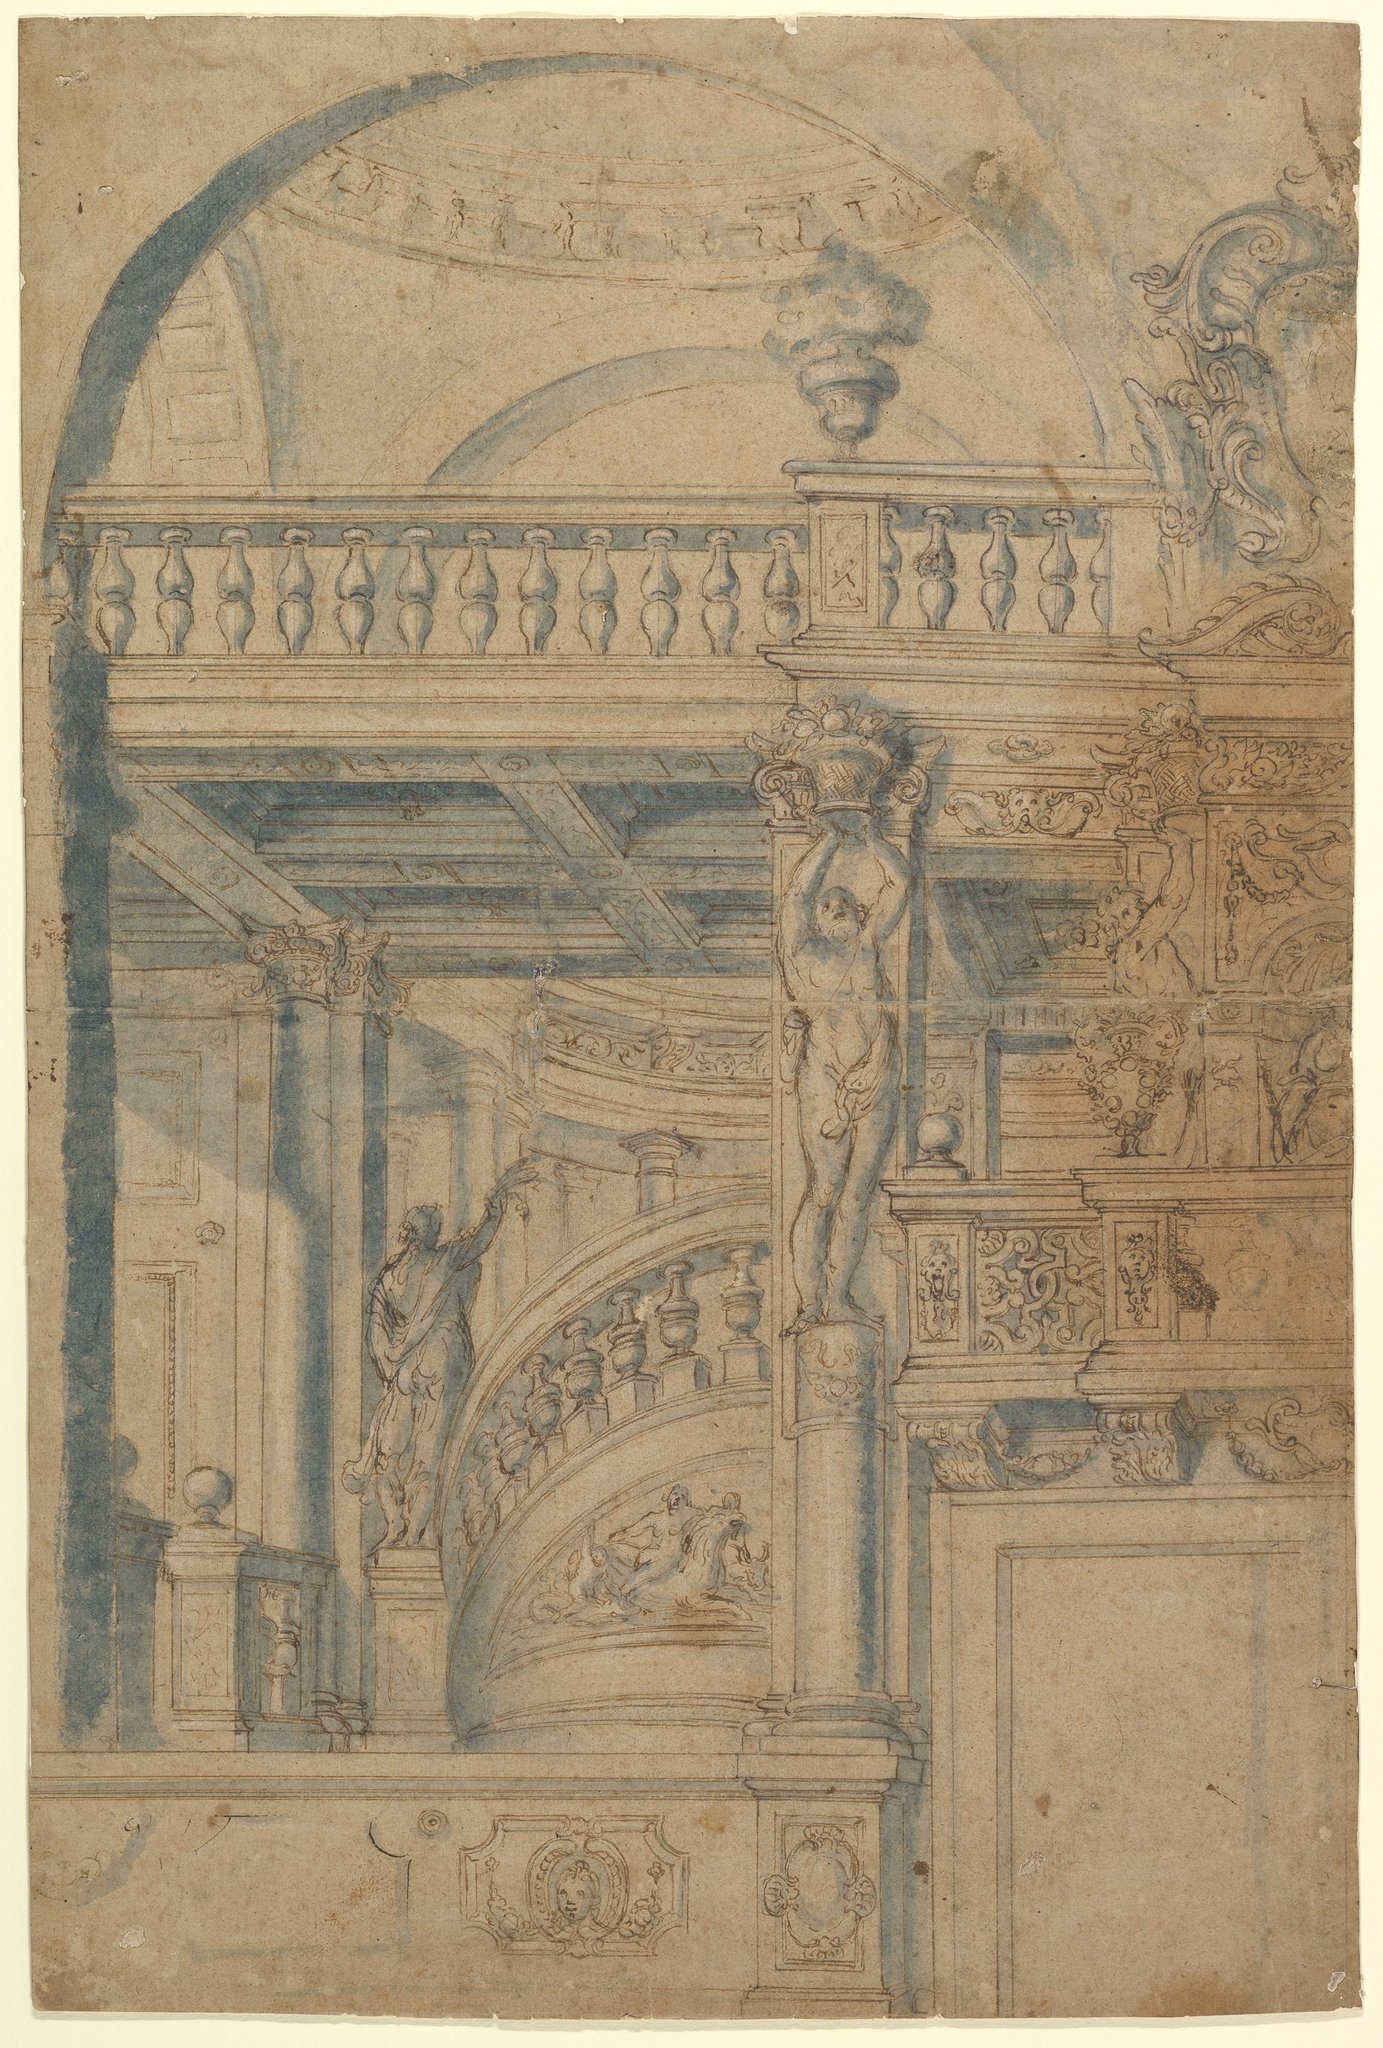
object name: drawing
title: Elevation of a Stairway and Balustrade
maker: anonymous, italian, 17th century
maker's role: artist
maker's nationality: italian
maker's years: 1600-1700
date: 1601-1700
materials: ink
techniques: brush, pen, wash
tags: architecture,stairs